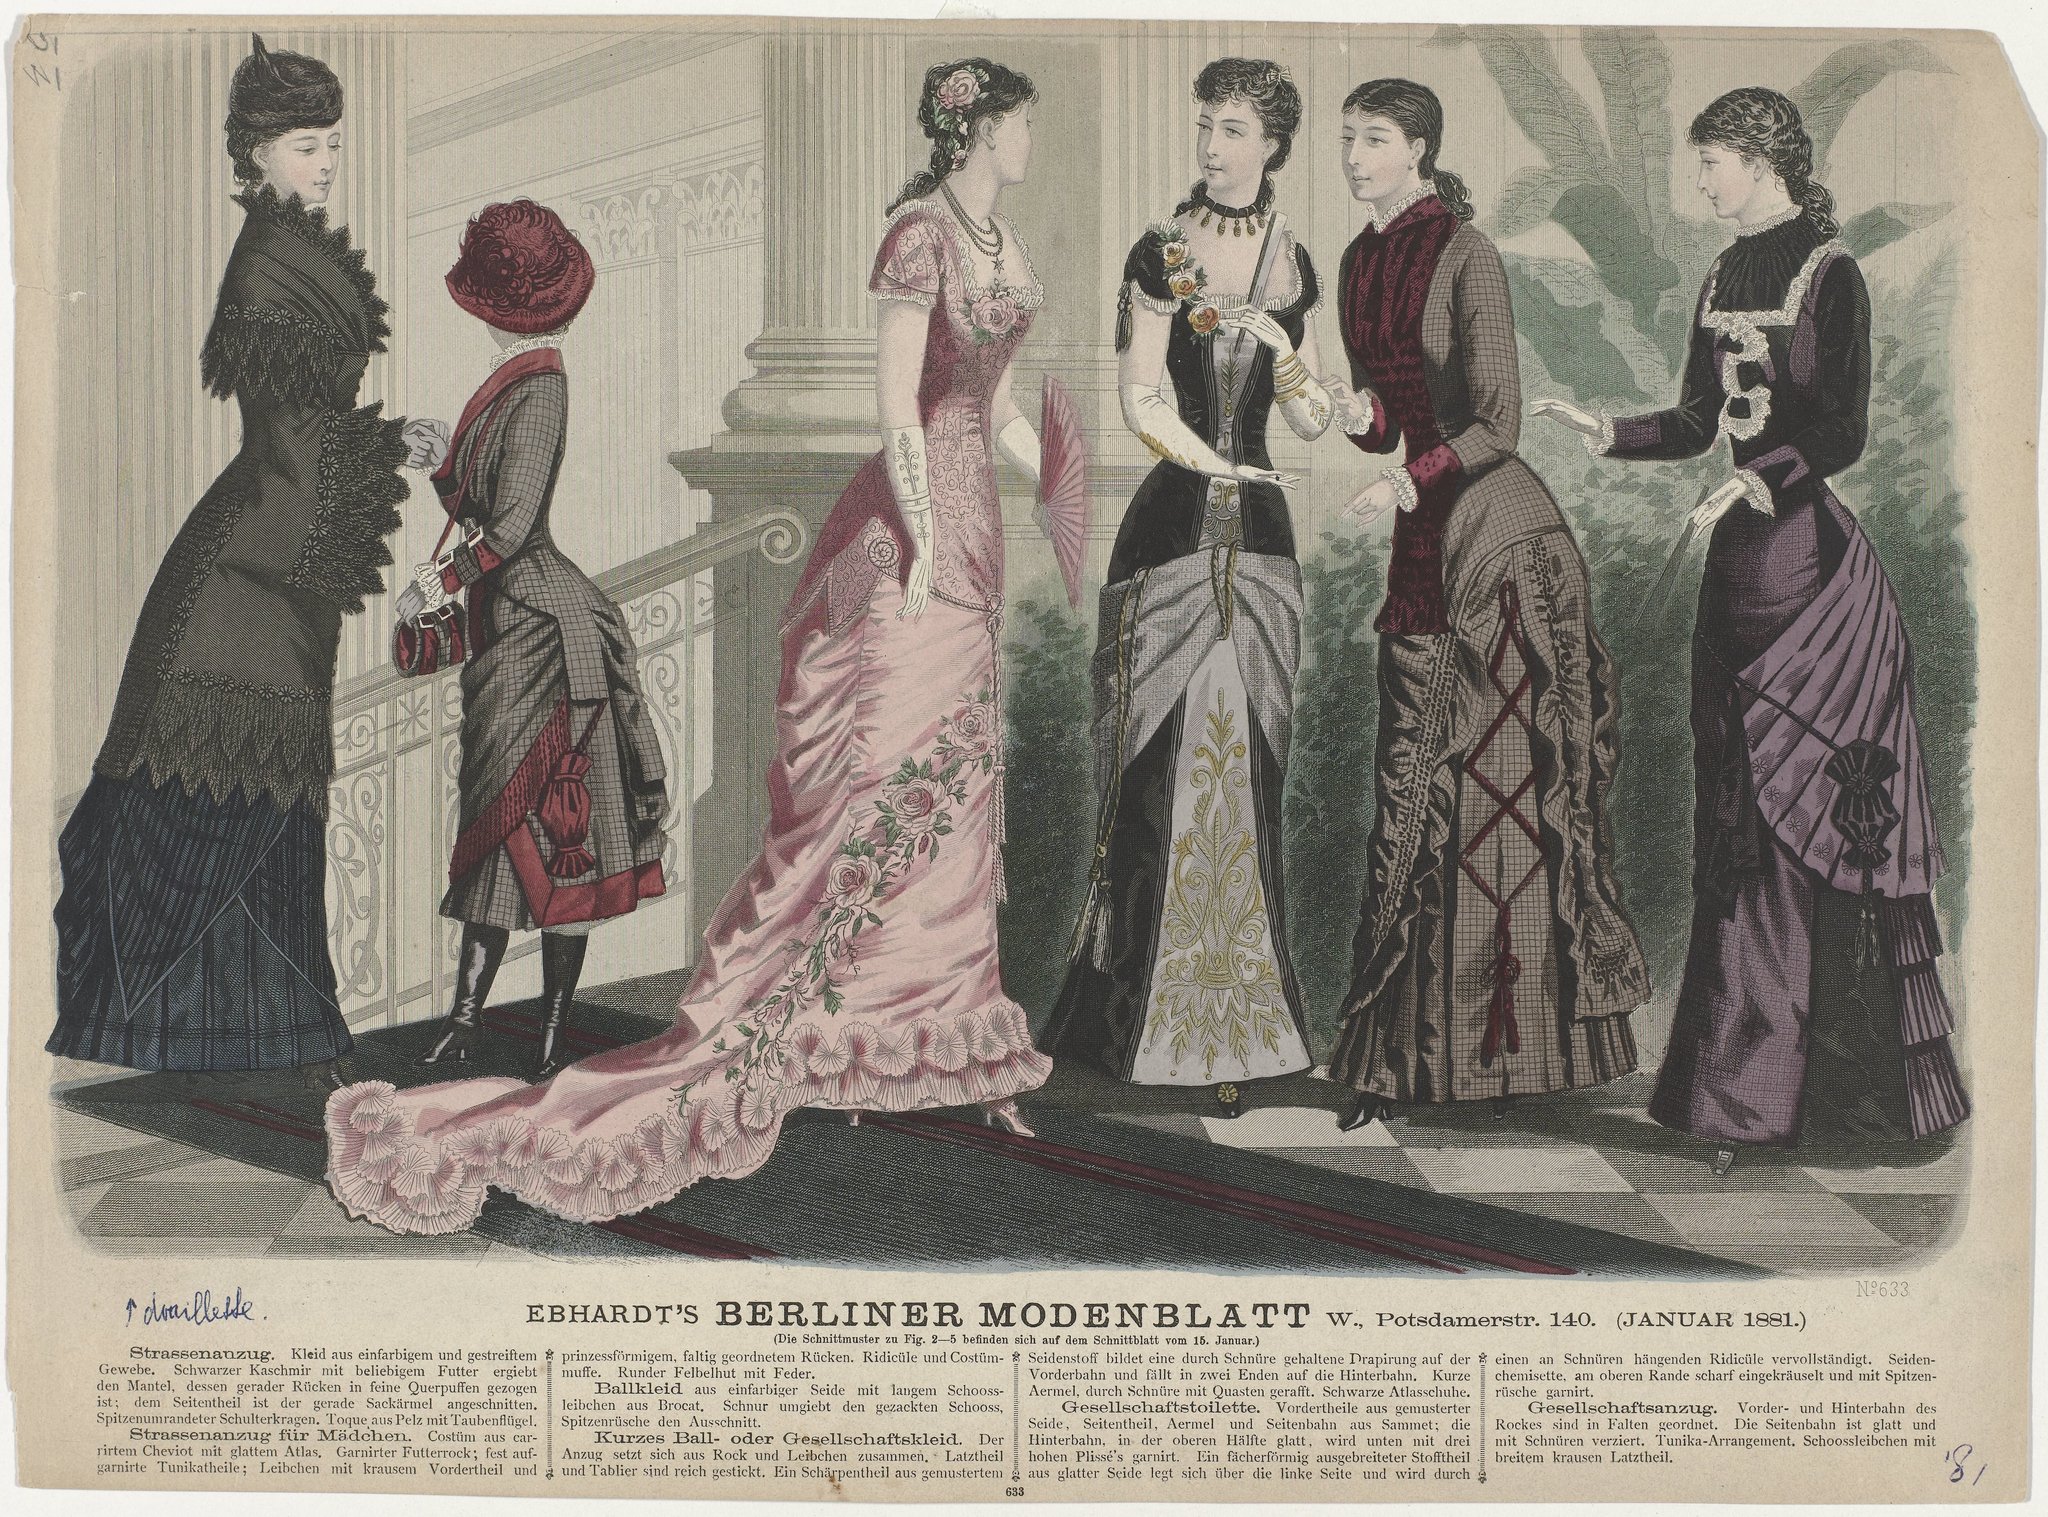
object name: fashion print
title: Berliner-Modenblatt, Januar 1881, No. 633 : Strassenanzug. Kleid aus einfarbigem (...)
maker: Anonymous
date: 1881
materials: paper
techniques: engraving, hand coloring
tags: head-gear: toque (+ women's clothes), bag (+ girls' clothes), dress, gown: ball gown (+ women's clothes), head-gear (+ girls' clothes), boots (+ girls' clothes), muff (+ girls' clothes), head-gear: toque (+ fur used for clothes), coat (+ women's clothes), fashion plates, gloves, mittens, etc. (+ women's clothes), dress, gown (+ women's clothes), fan (+ women's clothes), necklace (+ women's clothes)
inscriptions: caption: ‘(Die Schnittmuster zu Fig. 2-5 befinden sich auf dem Schnittnlat vom 15. Januar.) / Strassenanzug. Kleid aus einfarbigem und gestreiftem Gewebe. Schwarzer Kaschmir mit beliebigem Futter ergiebt den Mantel, dessen gerader Rücken in feine Querpuffen gezogen ist ; dem Seitentheil ist der gerade Sackärmel angeschnitten. Spitzenumrandeter Schulterkragen. toque aus Pelz mit Taubenflügel. / Strassenanzug für Mädchen. Costüm aus carrirtem Cheviot mit glattem Atlas. Garnirter Futterrock ; Fest aufgarnirte Tunikatheile ; Leibchen mit krausem Vordertheil und prinzessförmigem, faltig geordenetem Rücken. Ridicüle und Costüm-muffe. Runder Felbelhut mit Feder. / Ballkleid aus einfarbiger Seide mit langem Schoossleibchen aus Brocat. Schnur umgiebt den gezackten Schooss, Spitzzenrüsche den Ausschnitt. / Kurzes Ball-oder Gesellschaftskleid.... / Gesellschaftstoilette. ... / Gesellschaftensanzug. Vorder- und Hinterbahn des Rockes sind in Falten geordnet. Die Seitenbahn ist glatt und mit Schnüren verziert. Tunika-Arrangement. Schoossleibchen mit breitem krausen Latztheil.’, title: ‘EBHARDT'S BERLINER MODENBLATT’, address: ‘W., Potsdamerstr. 140. / (Januar 1881.)’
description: Zes figuren van links naar rechts: vrouw in 'tenue de ville': japon van effen en gestreepte stof en mantel van zwarte kasjmier. Toque van bont met duivenvleugel. Meisje in wandelkostuum. Handtas en mof. Vrouw in een baljapon met sleep. Vrouw in een 'gesellschaftstoilette' of japon met korte mouwen. Twee vrouwen in een 'gesellschaftsanzug'. Prent uit het modetijdschrift Berliner-Modenblatt (1879-1881).